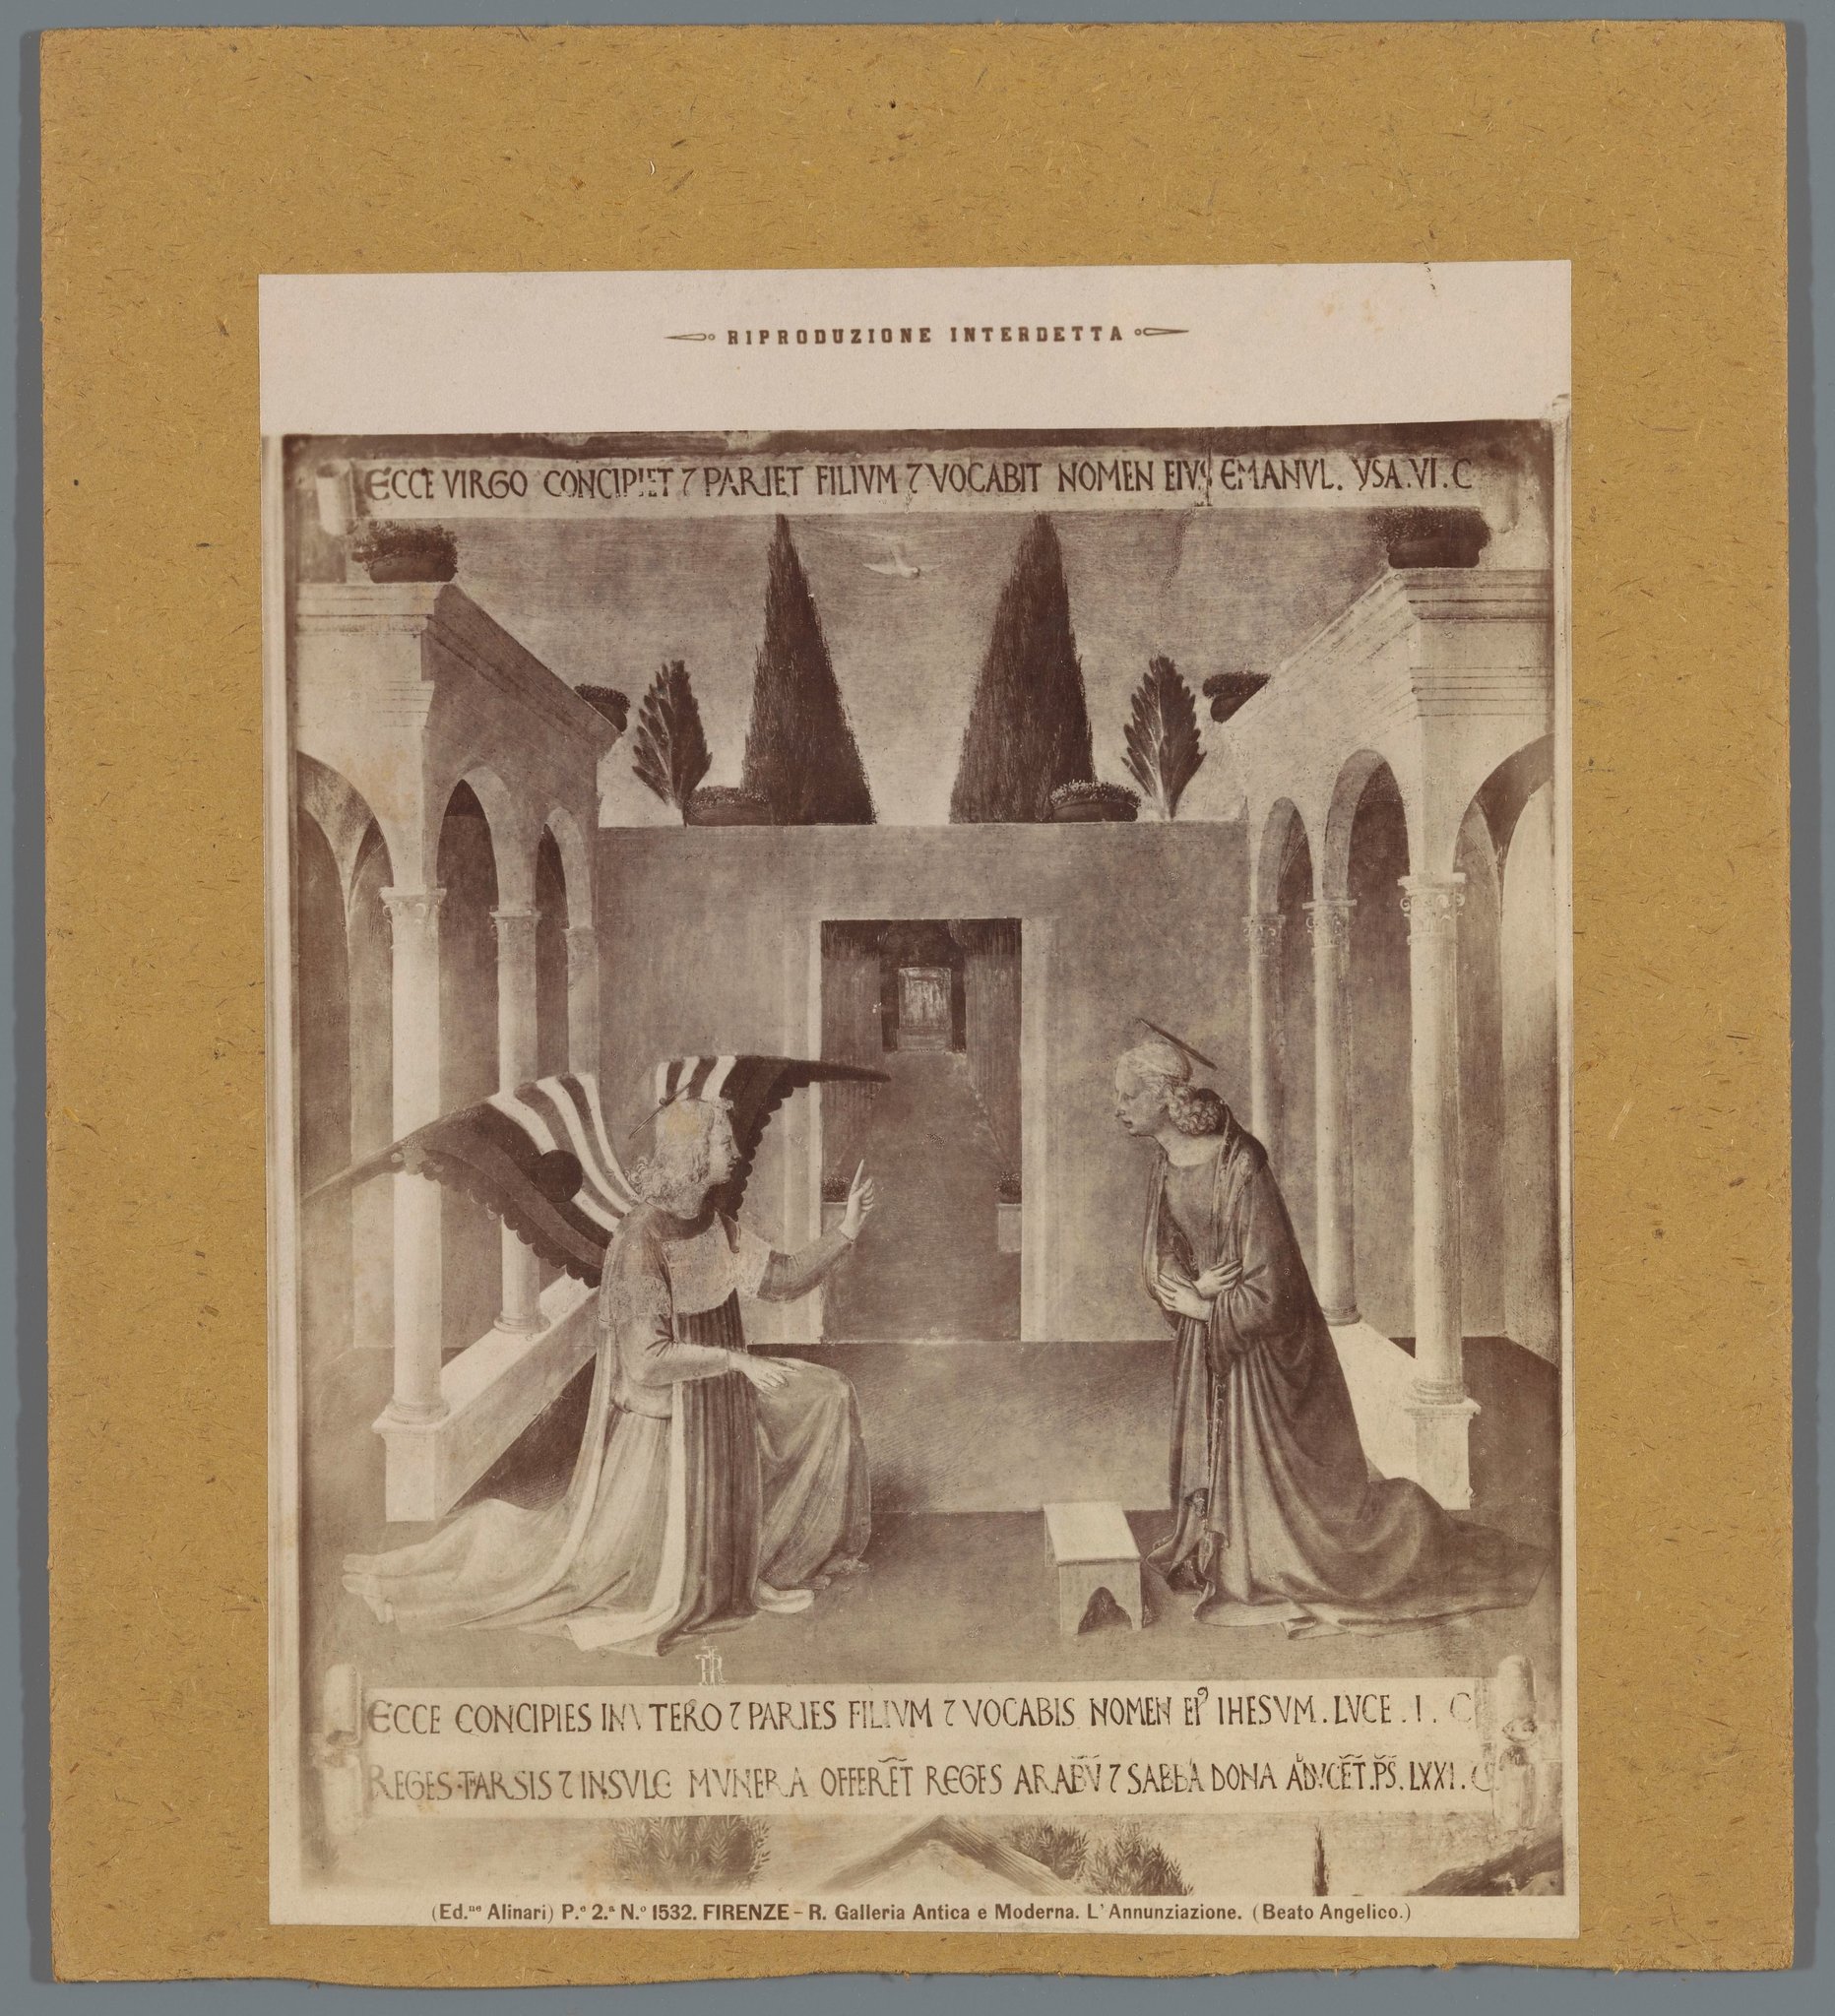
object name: photograph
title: Fotoreproductie van een schilderij door Fra Angelico, voorstellende de Annunciatie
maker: fra angelico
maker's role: painter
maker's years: 1400-1455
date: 1875-1900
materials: cardboard, photographic support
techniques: albumen print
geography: italy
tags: the annunciation: mary kneeling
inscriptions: collector's mark: Lugt 3937, inscription:, number: ‘P.e 2.a N.o 1532.’